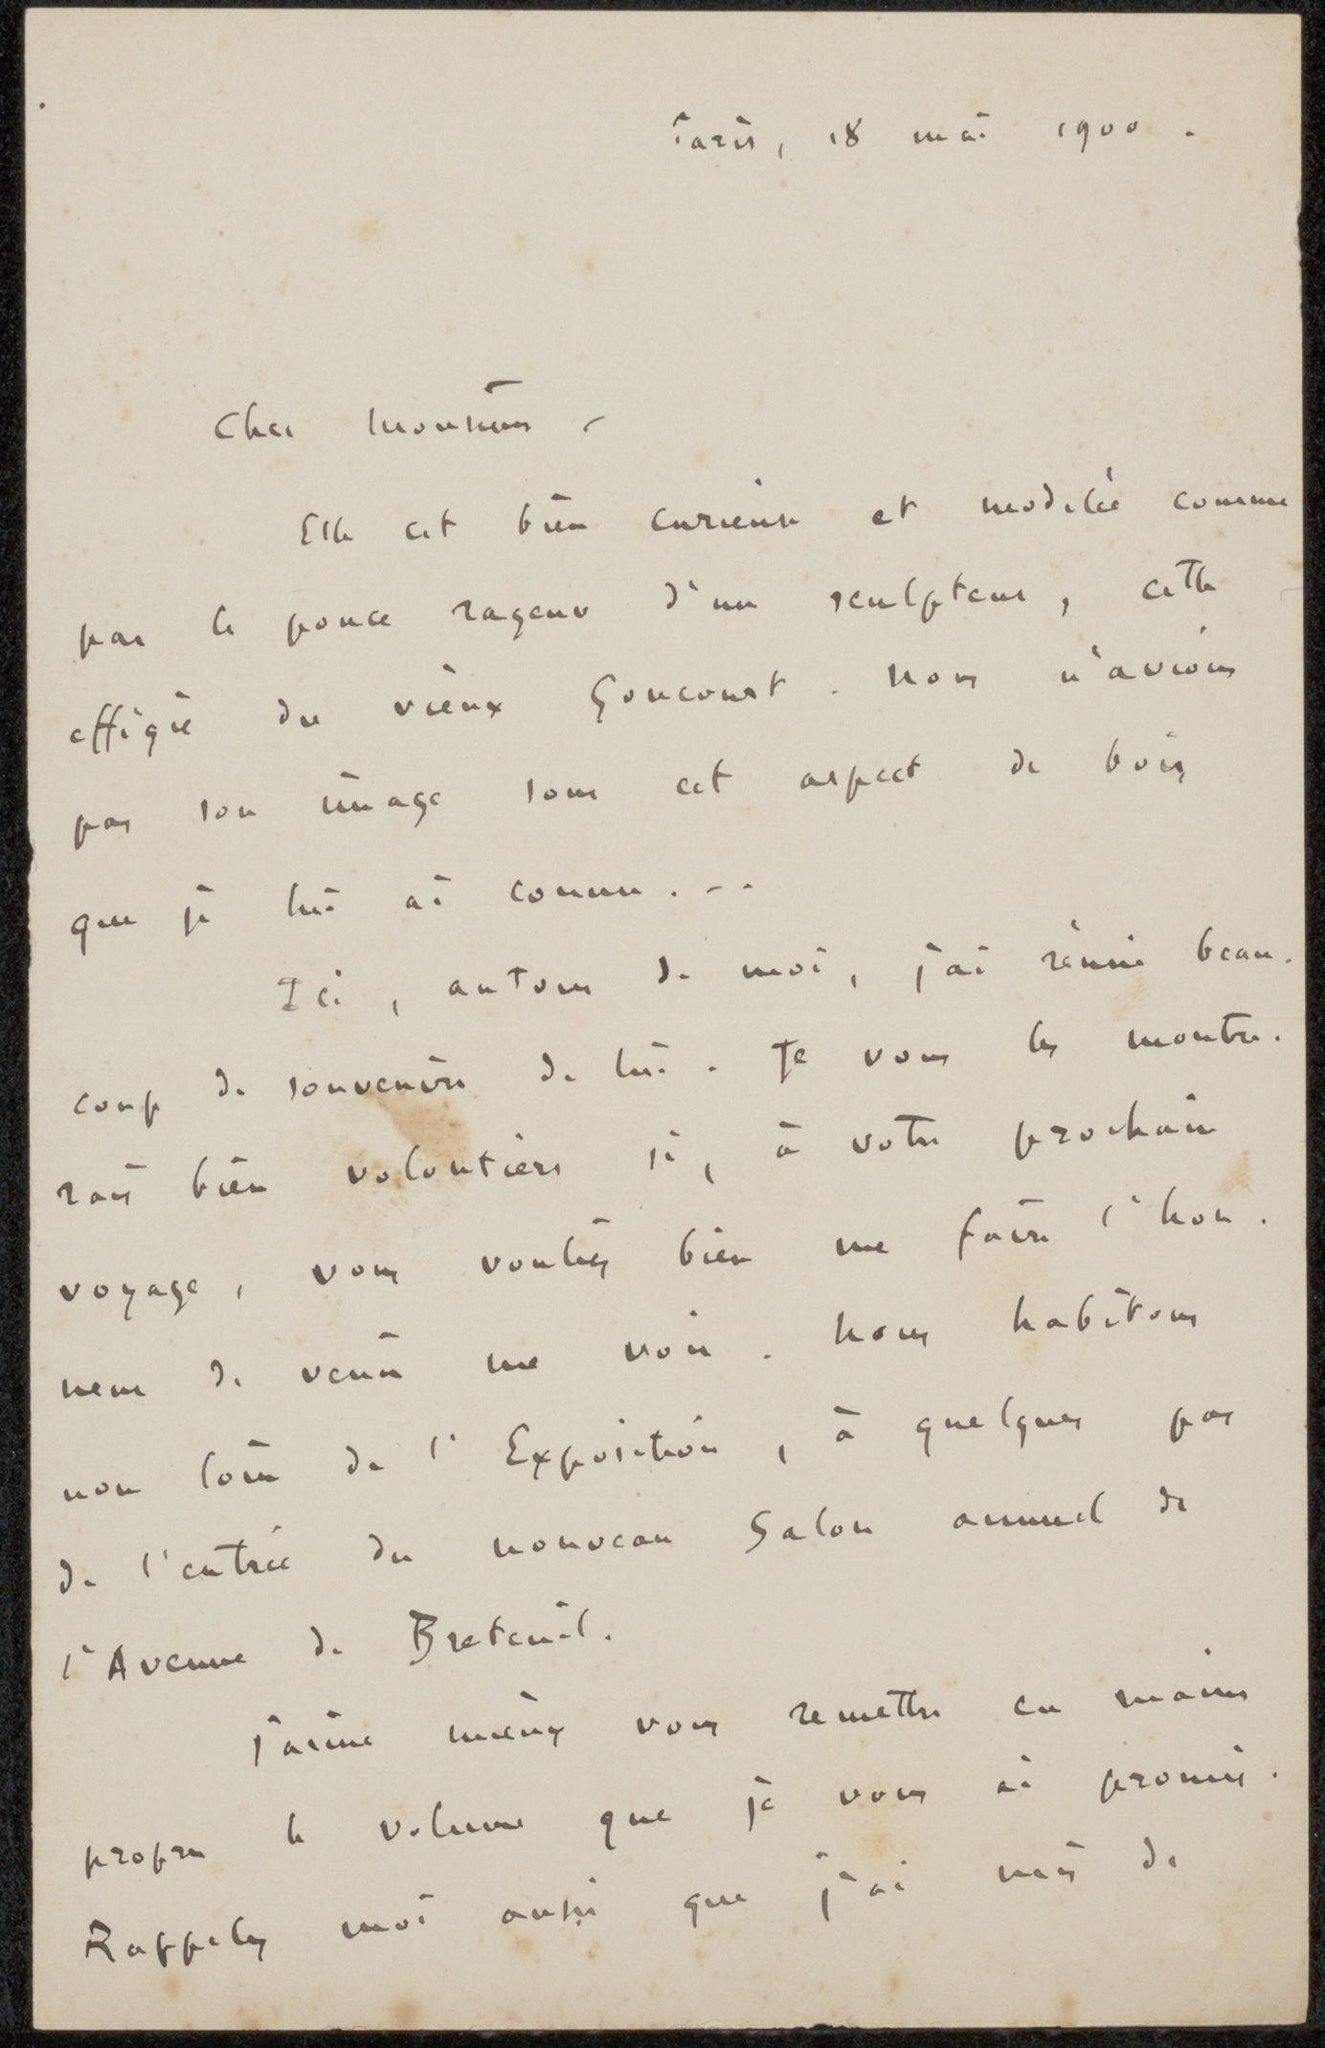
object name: letter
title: Brief aan Philip Zilcken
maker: alidor delzant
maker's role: advocaat, auteur, kunstverzamelaar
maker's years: 1848-1905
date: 1900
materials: ink, paper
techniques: pen, writing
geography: paris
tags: edmond de goncourt, paris, print maker, félix bracquemond, the hague, painter, draughtsman, philip zilcken, the graphic arts, sculpture, temporary exhibition, 'salon', historical persons (portraits and scenes from the life)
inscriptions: collector's mark: ‘RPK’